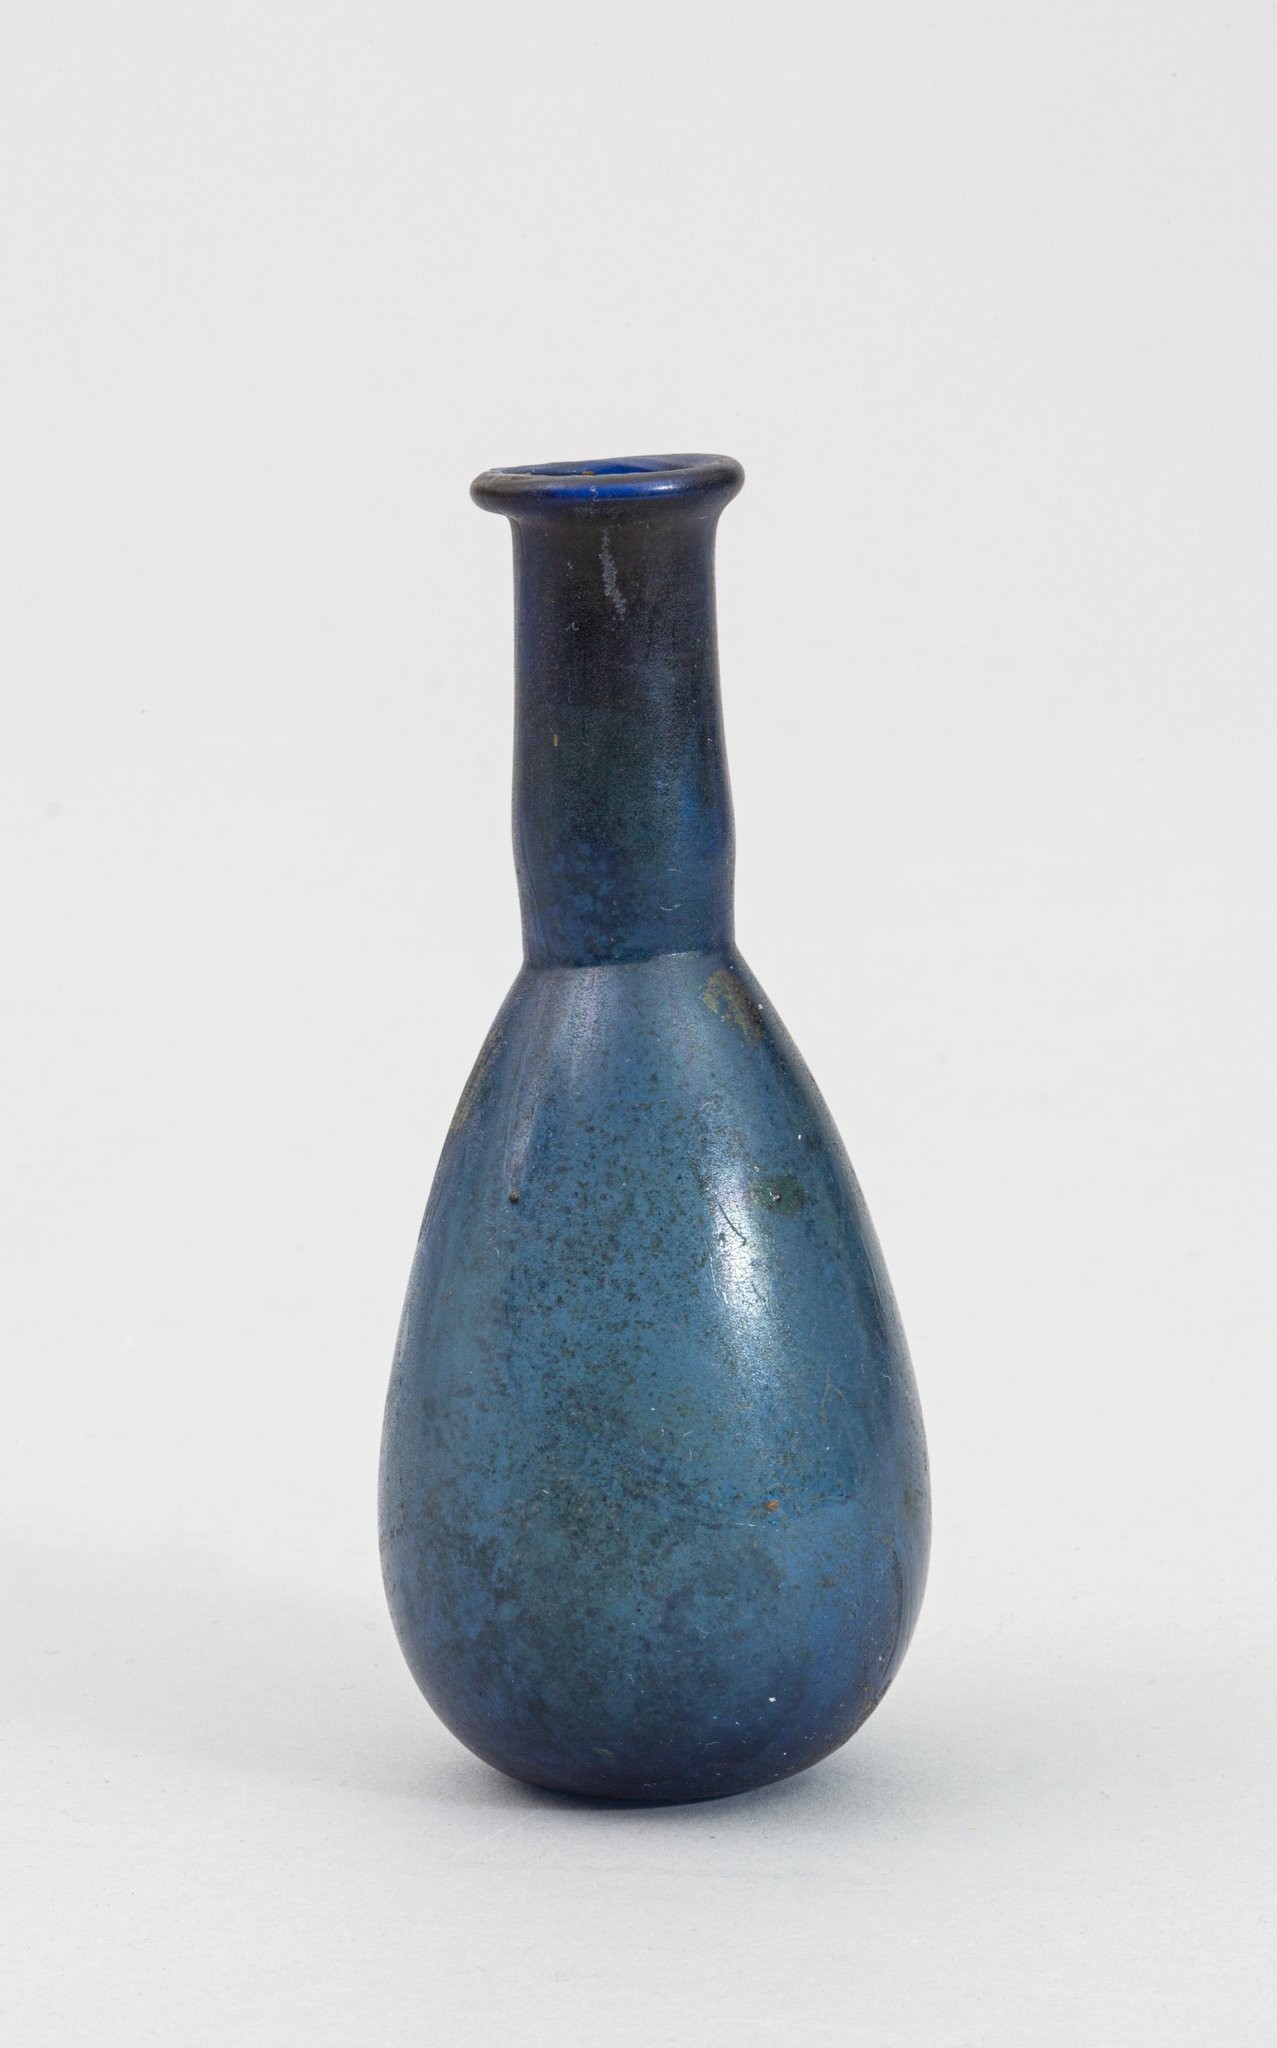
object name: perfume bottle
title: Glass perfume bottle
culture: roman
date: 1-100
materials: glass